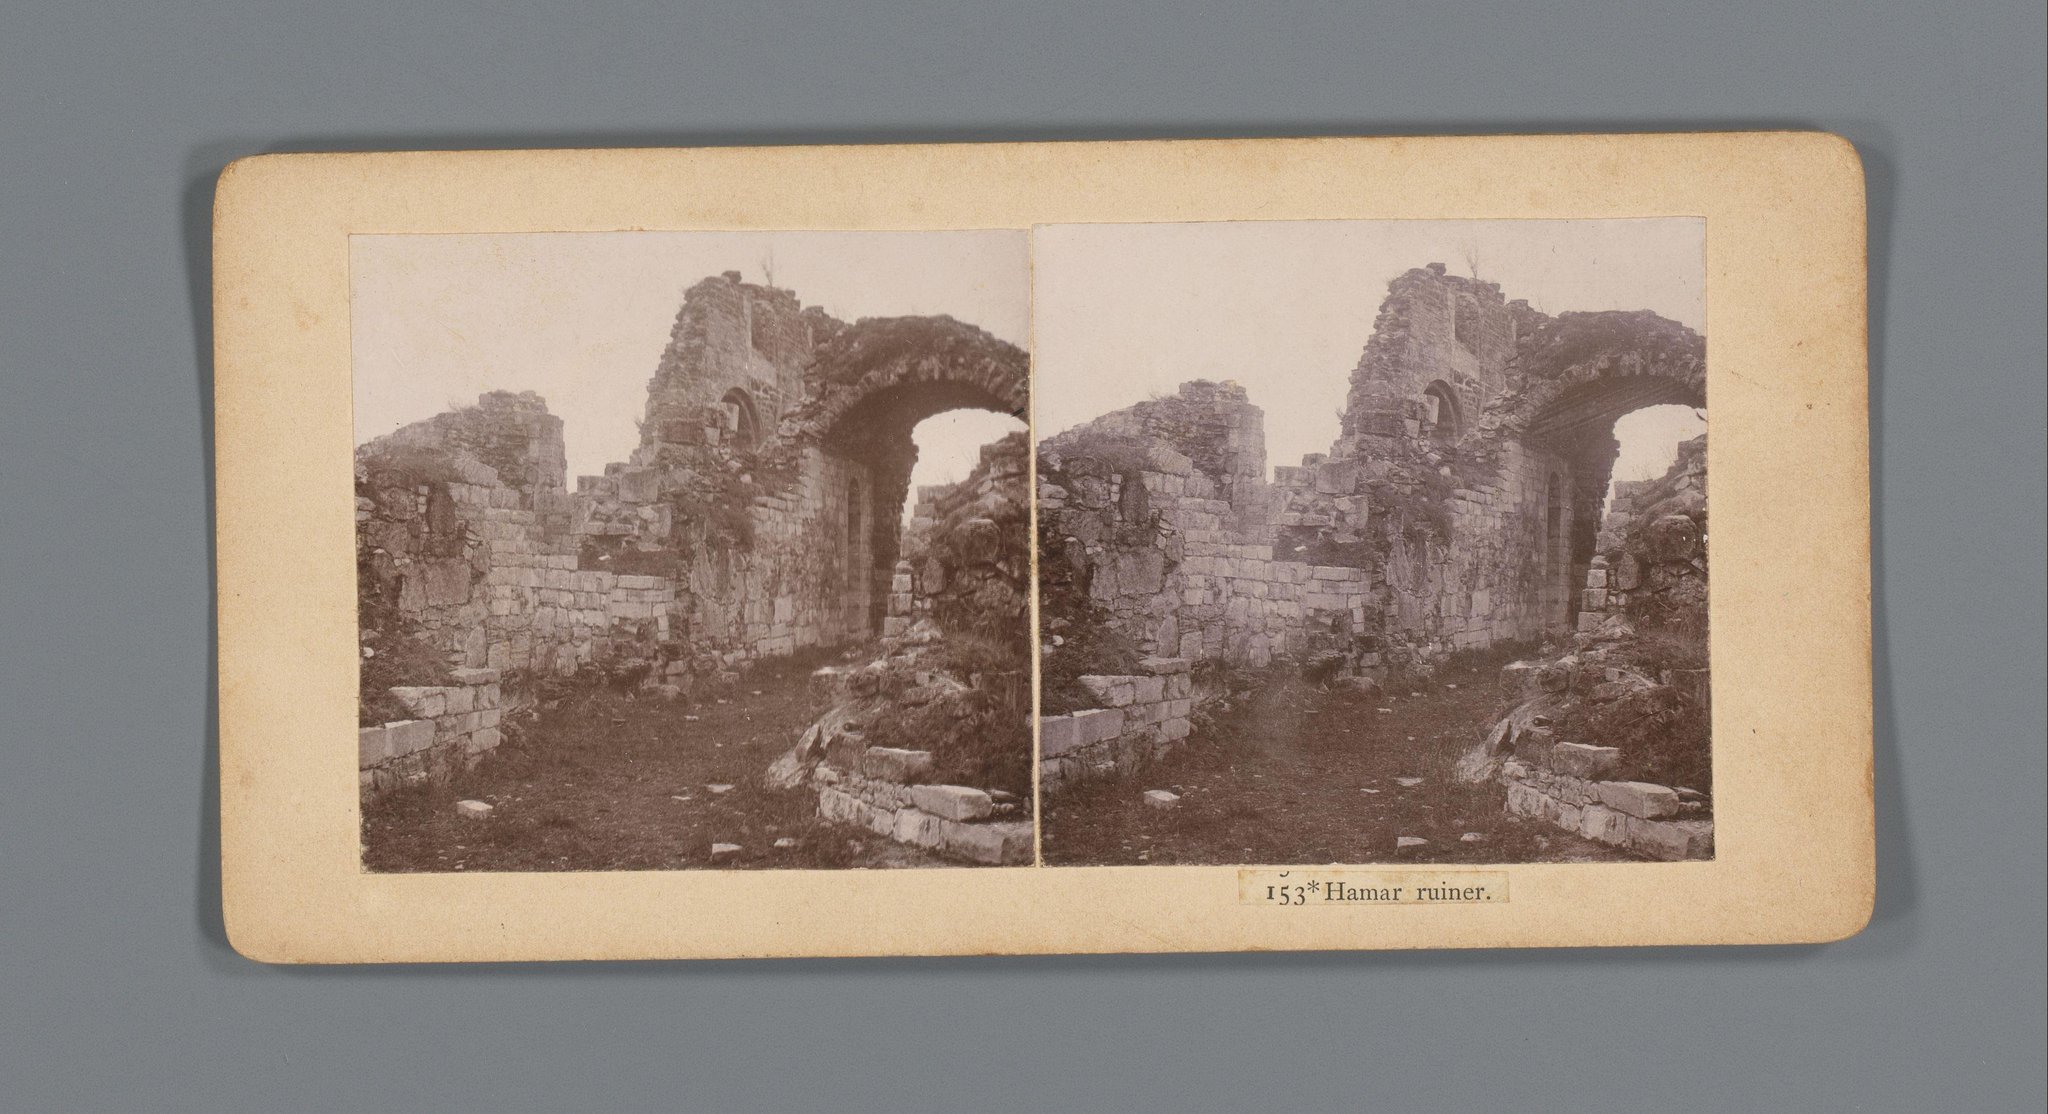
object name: stereograph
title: Hamar ruiner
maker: Anonymous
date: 1880-1900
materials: cardboard, photographic support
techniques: collodion silver print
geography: hamar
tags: ruin of a building ~ architecture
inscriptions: stamp: ‘JAC MOULIJN/ DEN HAAG’, number: ‘153’, number: ‘153*’